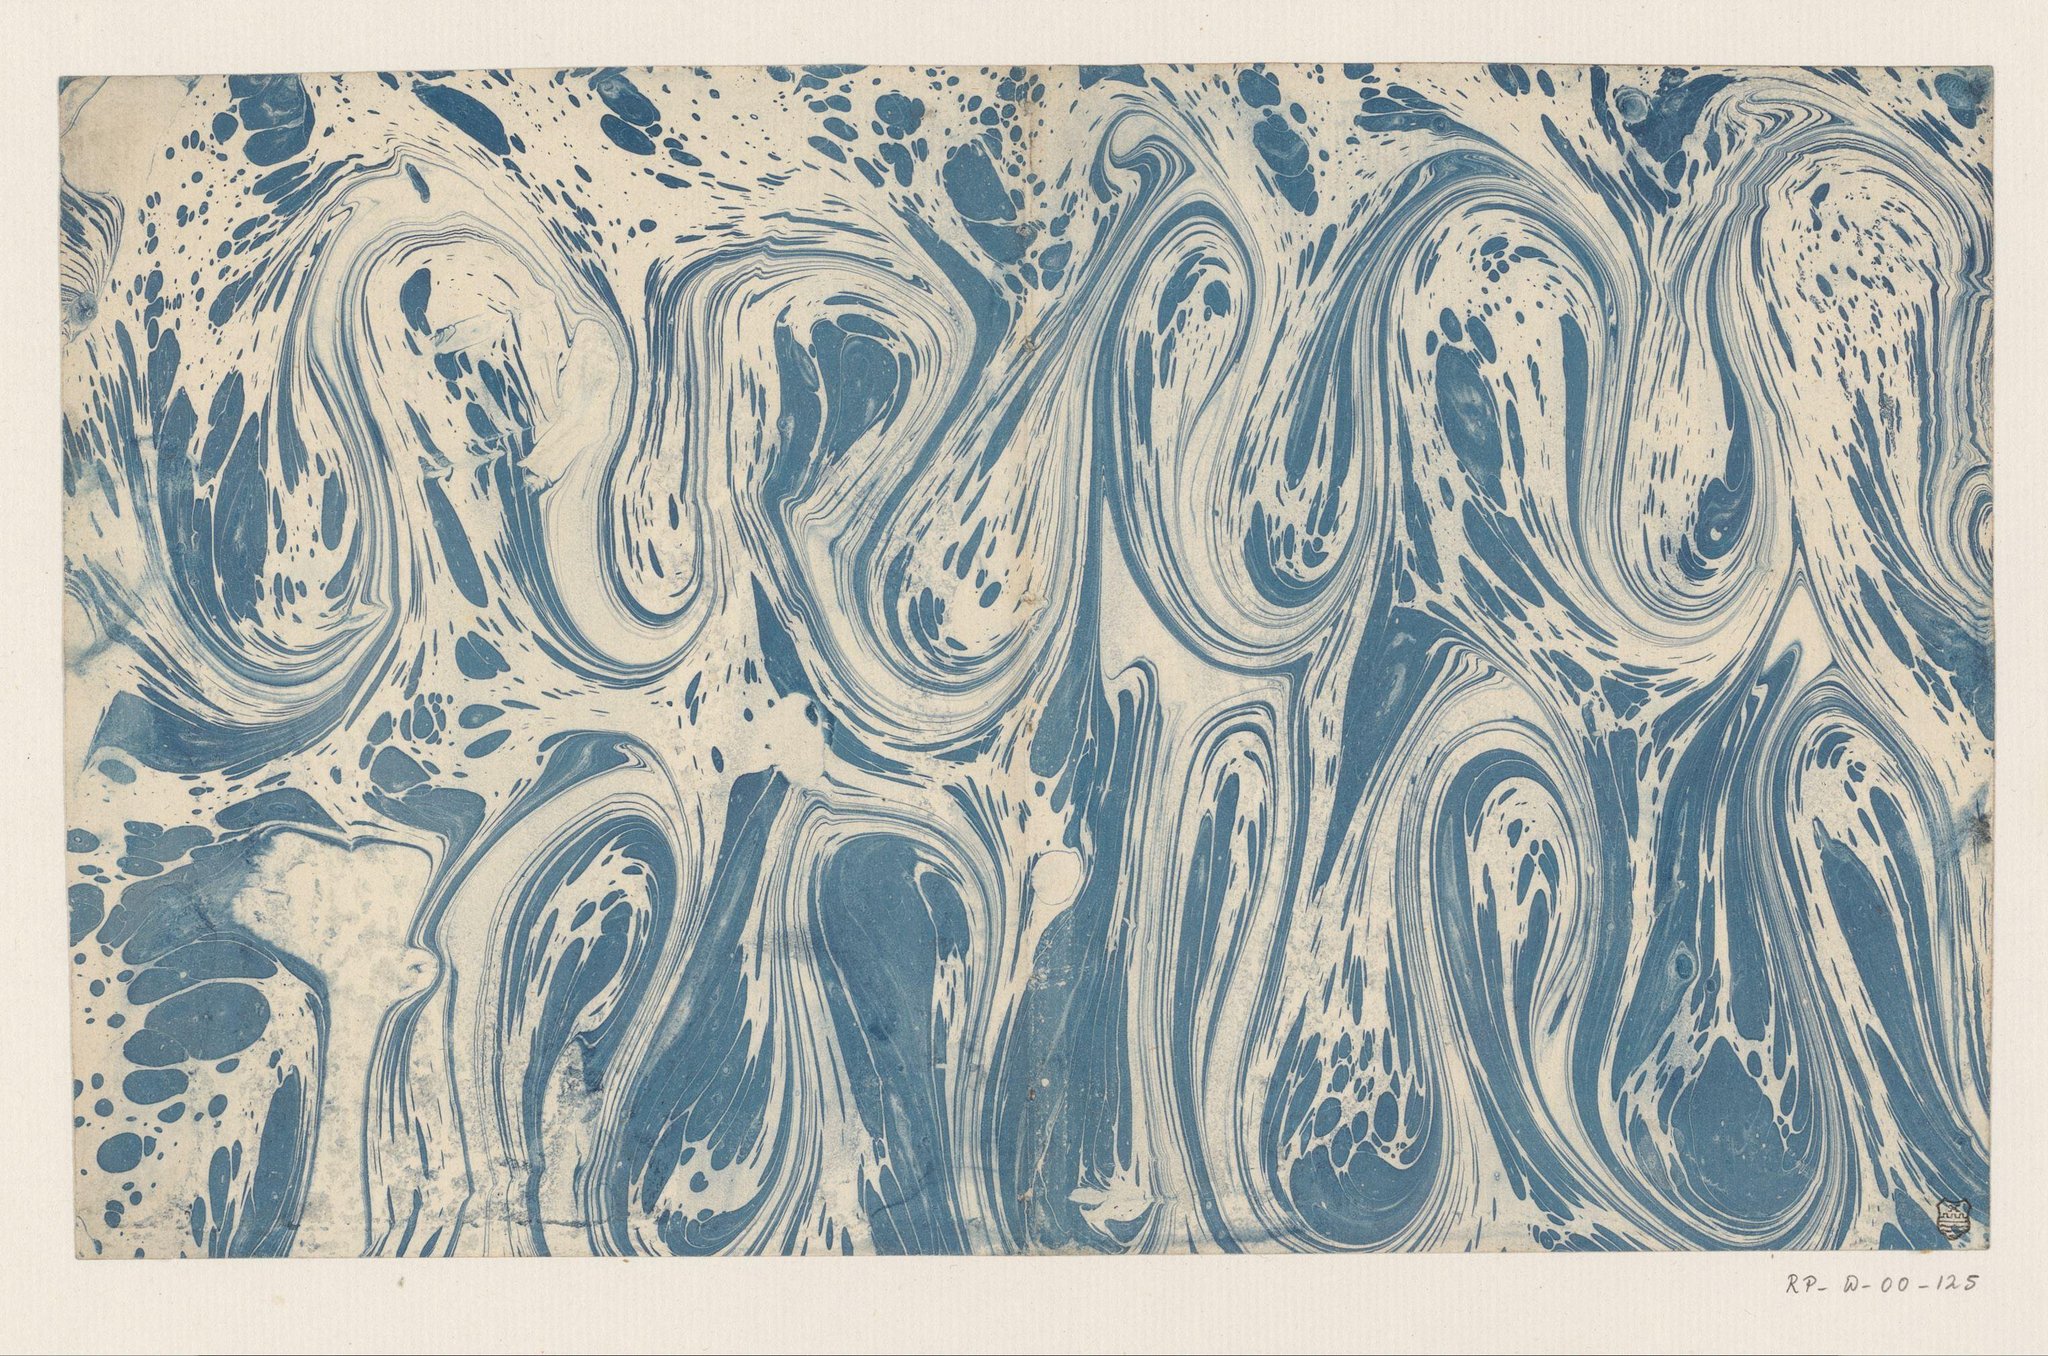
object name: wrapper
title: Golfmarmer in blauw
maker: Anonymous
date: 1700-1850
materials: paper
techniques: marbling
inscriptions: collector's mark: Lugt 2760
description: Golfmarmer in blauw. Gebruikt als omslag.